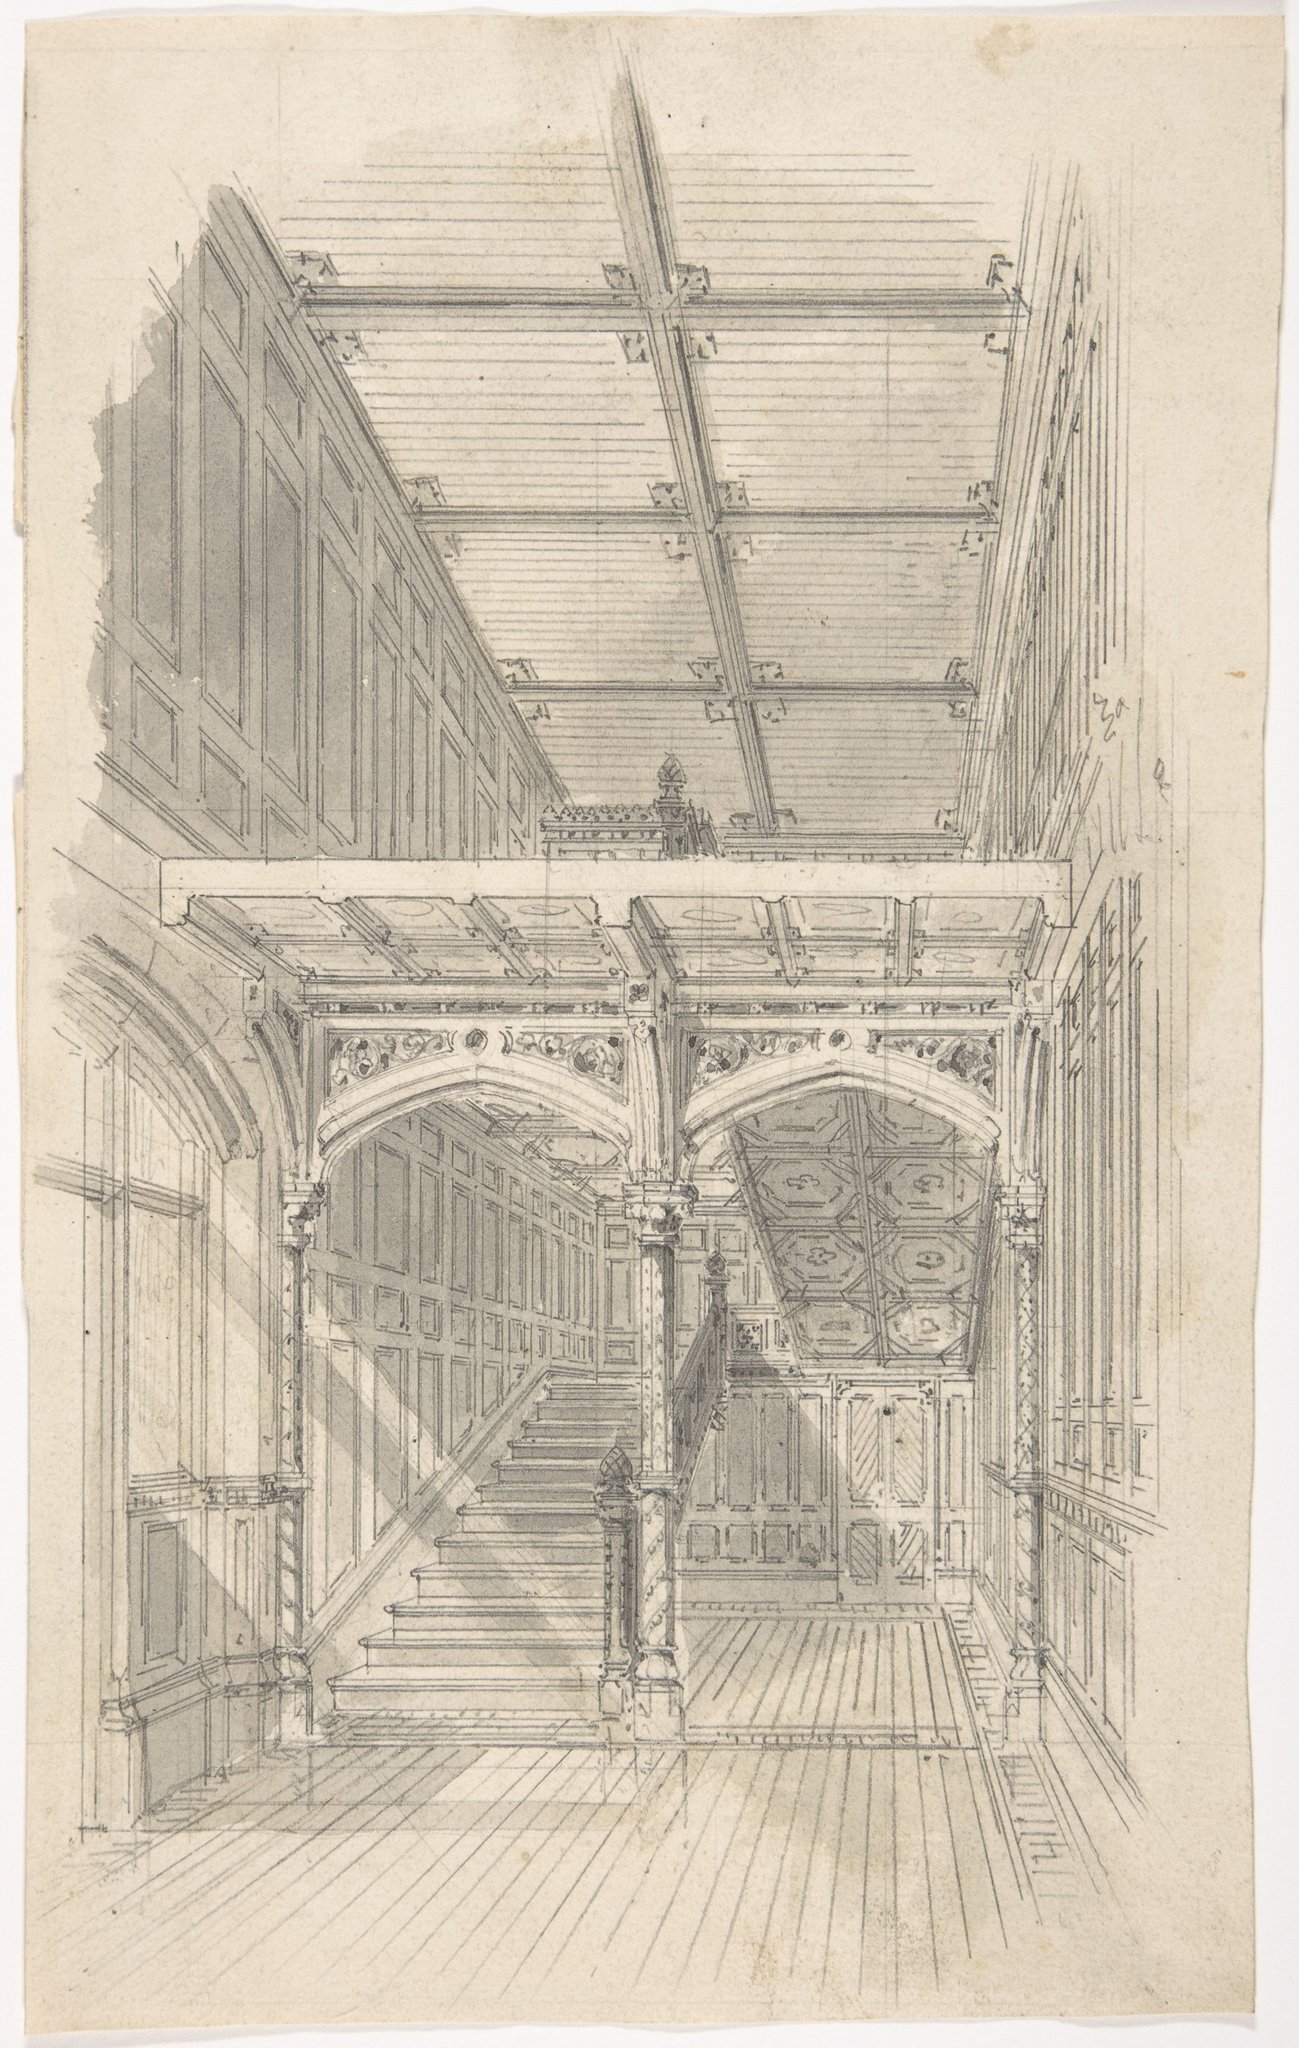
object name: drawing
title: Design for a Tudor Paneled Hall and Staircase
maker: anonymous, british, 19th century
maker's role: artist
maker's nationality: british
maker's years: 1800-1900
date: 1851-1900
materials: graphite, ink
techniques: brush, pen, wash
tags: architecture,stairs,interiors